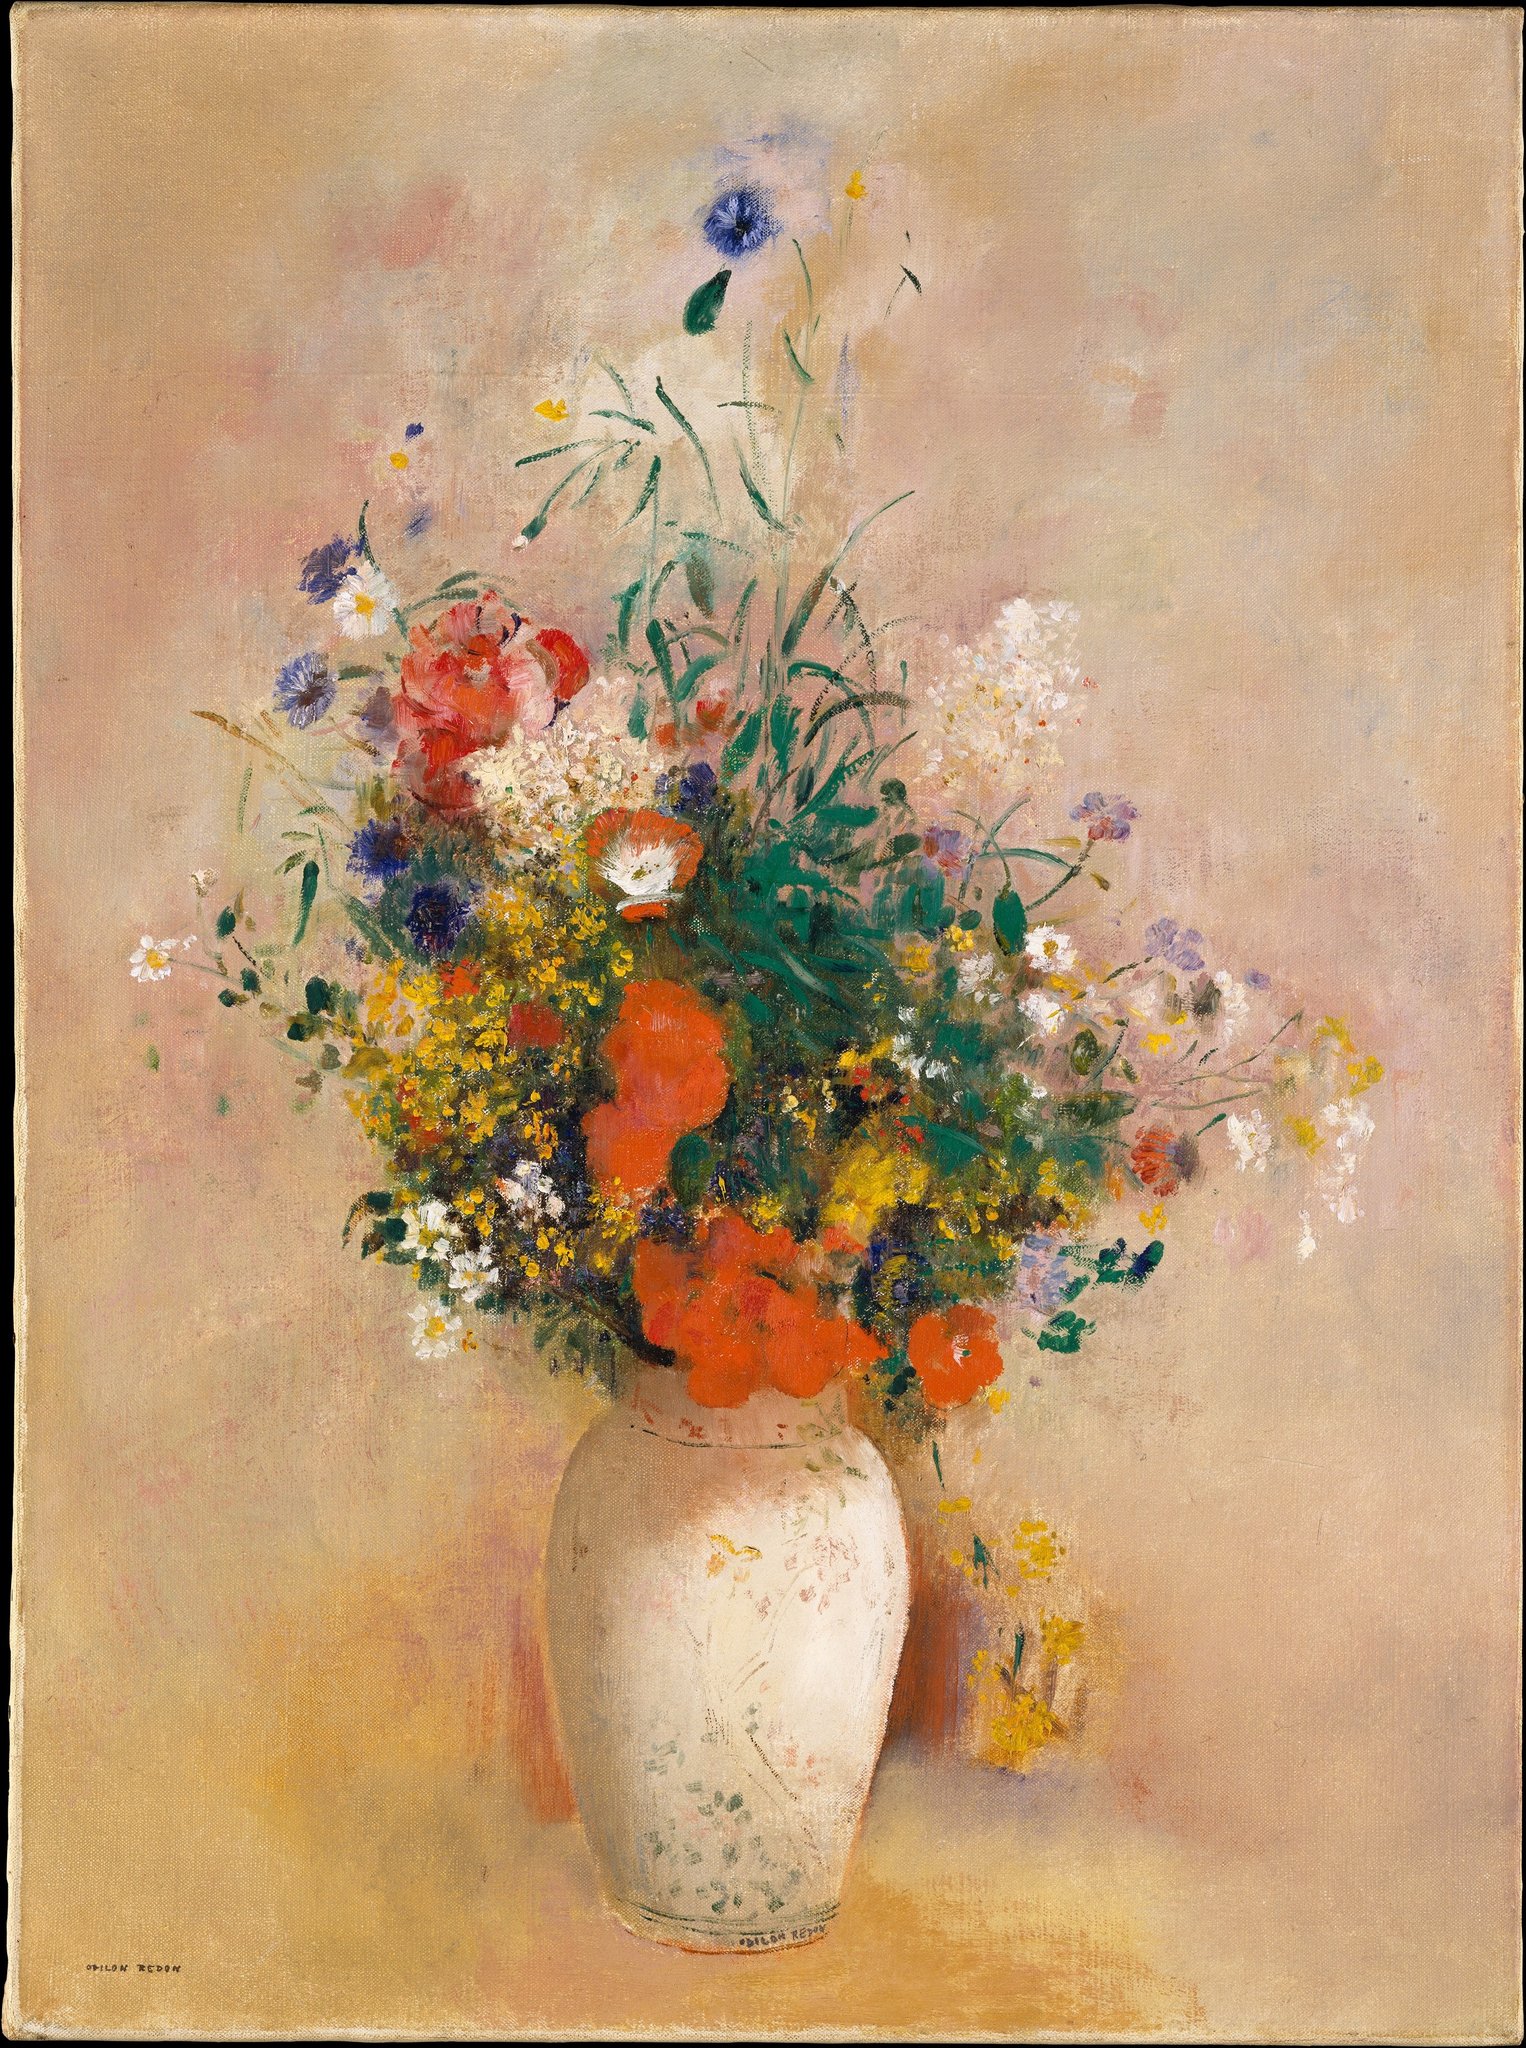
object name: painting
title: Vase of Flowers (Pink Background)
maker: odilon redon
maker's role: artist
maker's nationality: french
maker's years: 1840-1916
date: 1906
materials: canvas, oil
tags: flowers,vases